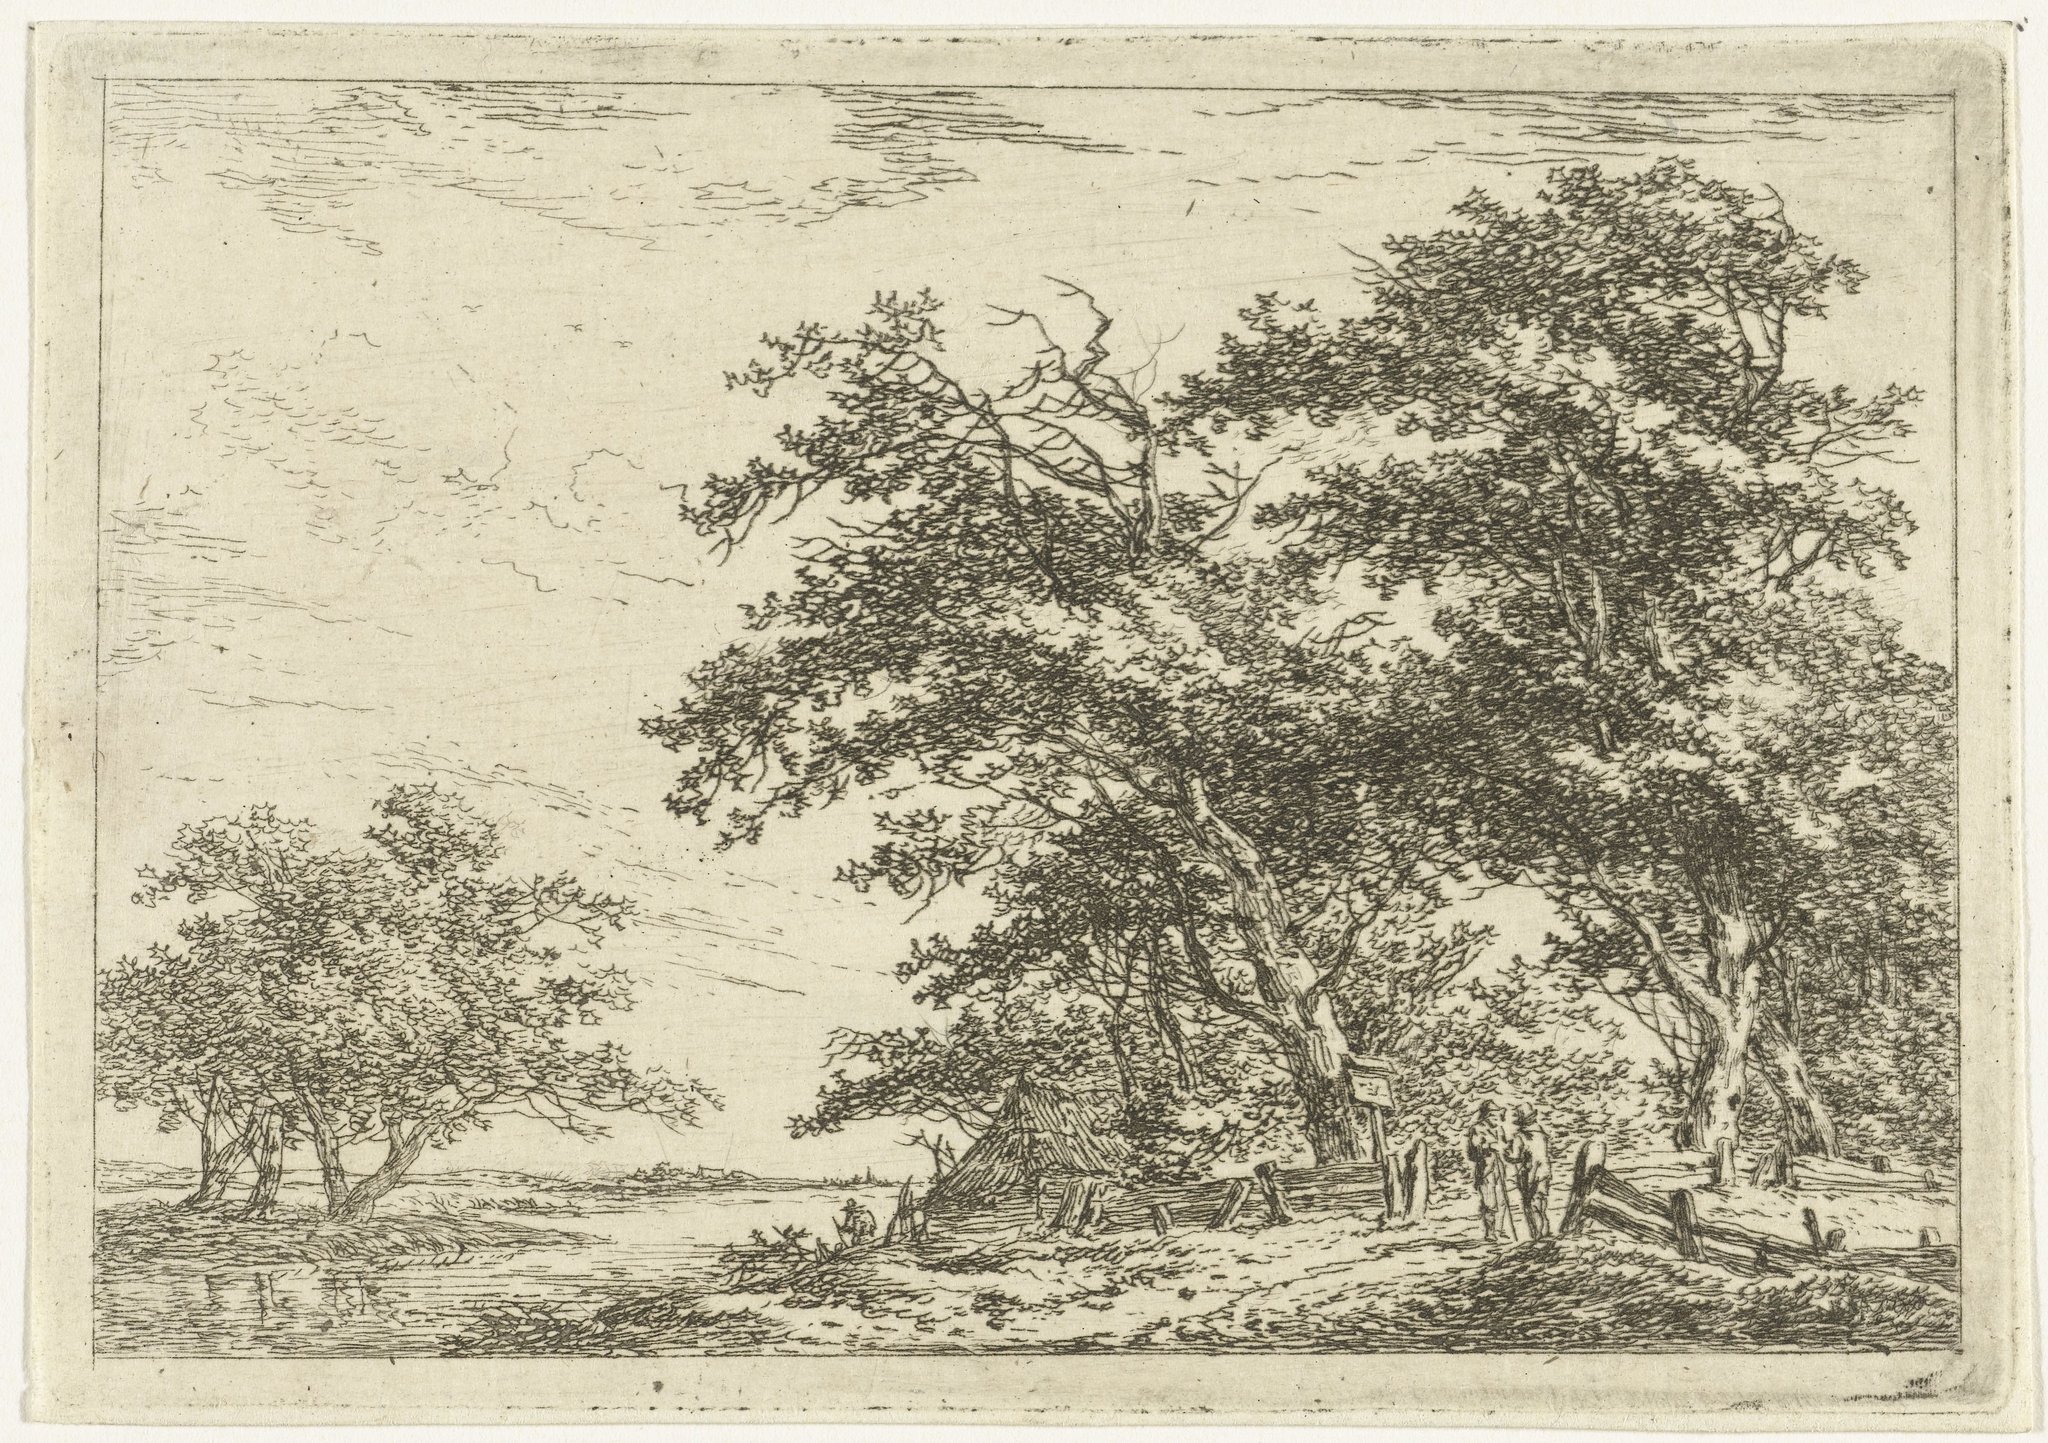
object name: print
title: Pratende mannen bij hek aan bosrand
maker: hermanus van brussel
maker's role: draughtsman, print maker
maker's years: 1763-1815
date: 1800-1815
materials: paper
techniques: etching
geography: netherlands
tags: fence, wall, paling, forest, wood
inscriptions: collector's mark: Lugt 2228